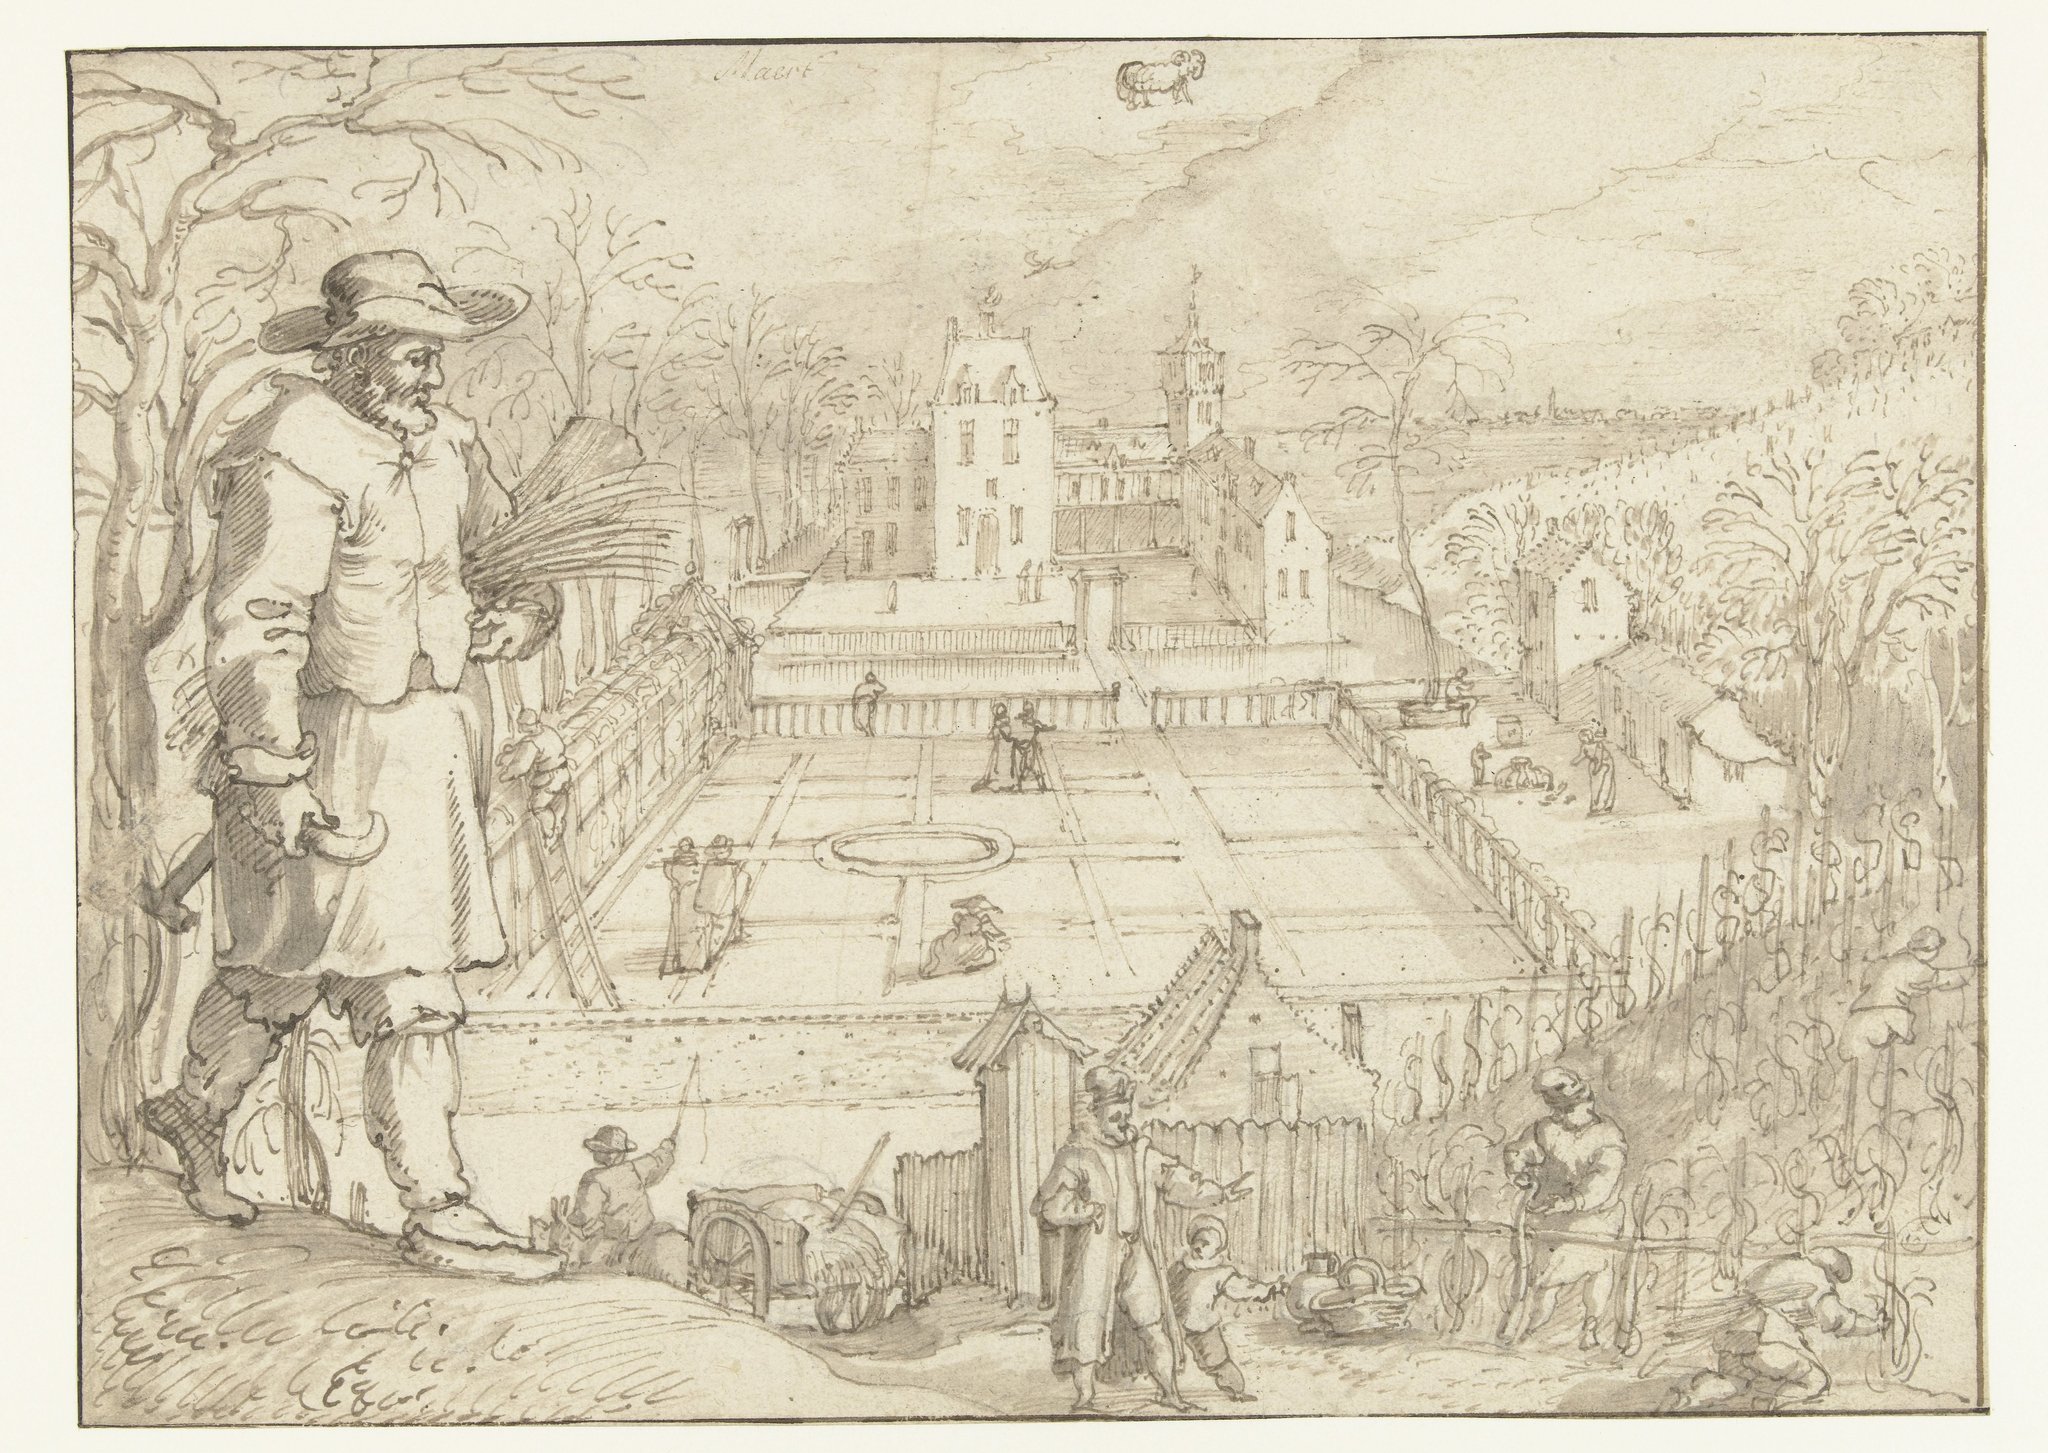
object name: design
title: Maart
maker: joos de momper (ii)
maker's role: draughtsman, painter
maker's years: 1564-1635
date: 1590-1610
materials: chalk, ink, paper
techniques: brush, pen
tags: vineyard, march and its 'labours', french or architectonic garden; formal garden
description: De maand maart. Links een man met een snoeimes en takken, rechts een wijngaard. Centraal een kasteel met ornamentele tuin. Ontwerp voor een prent.